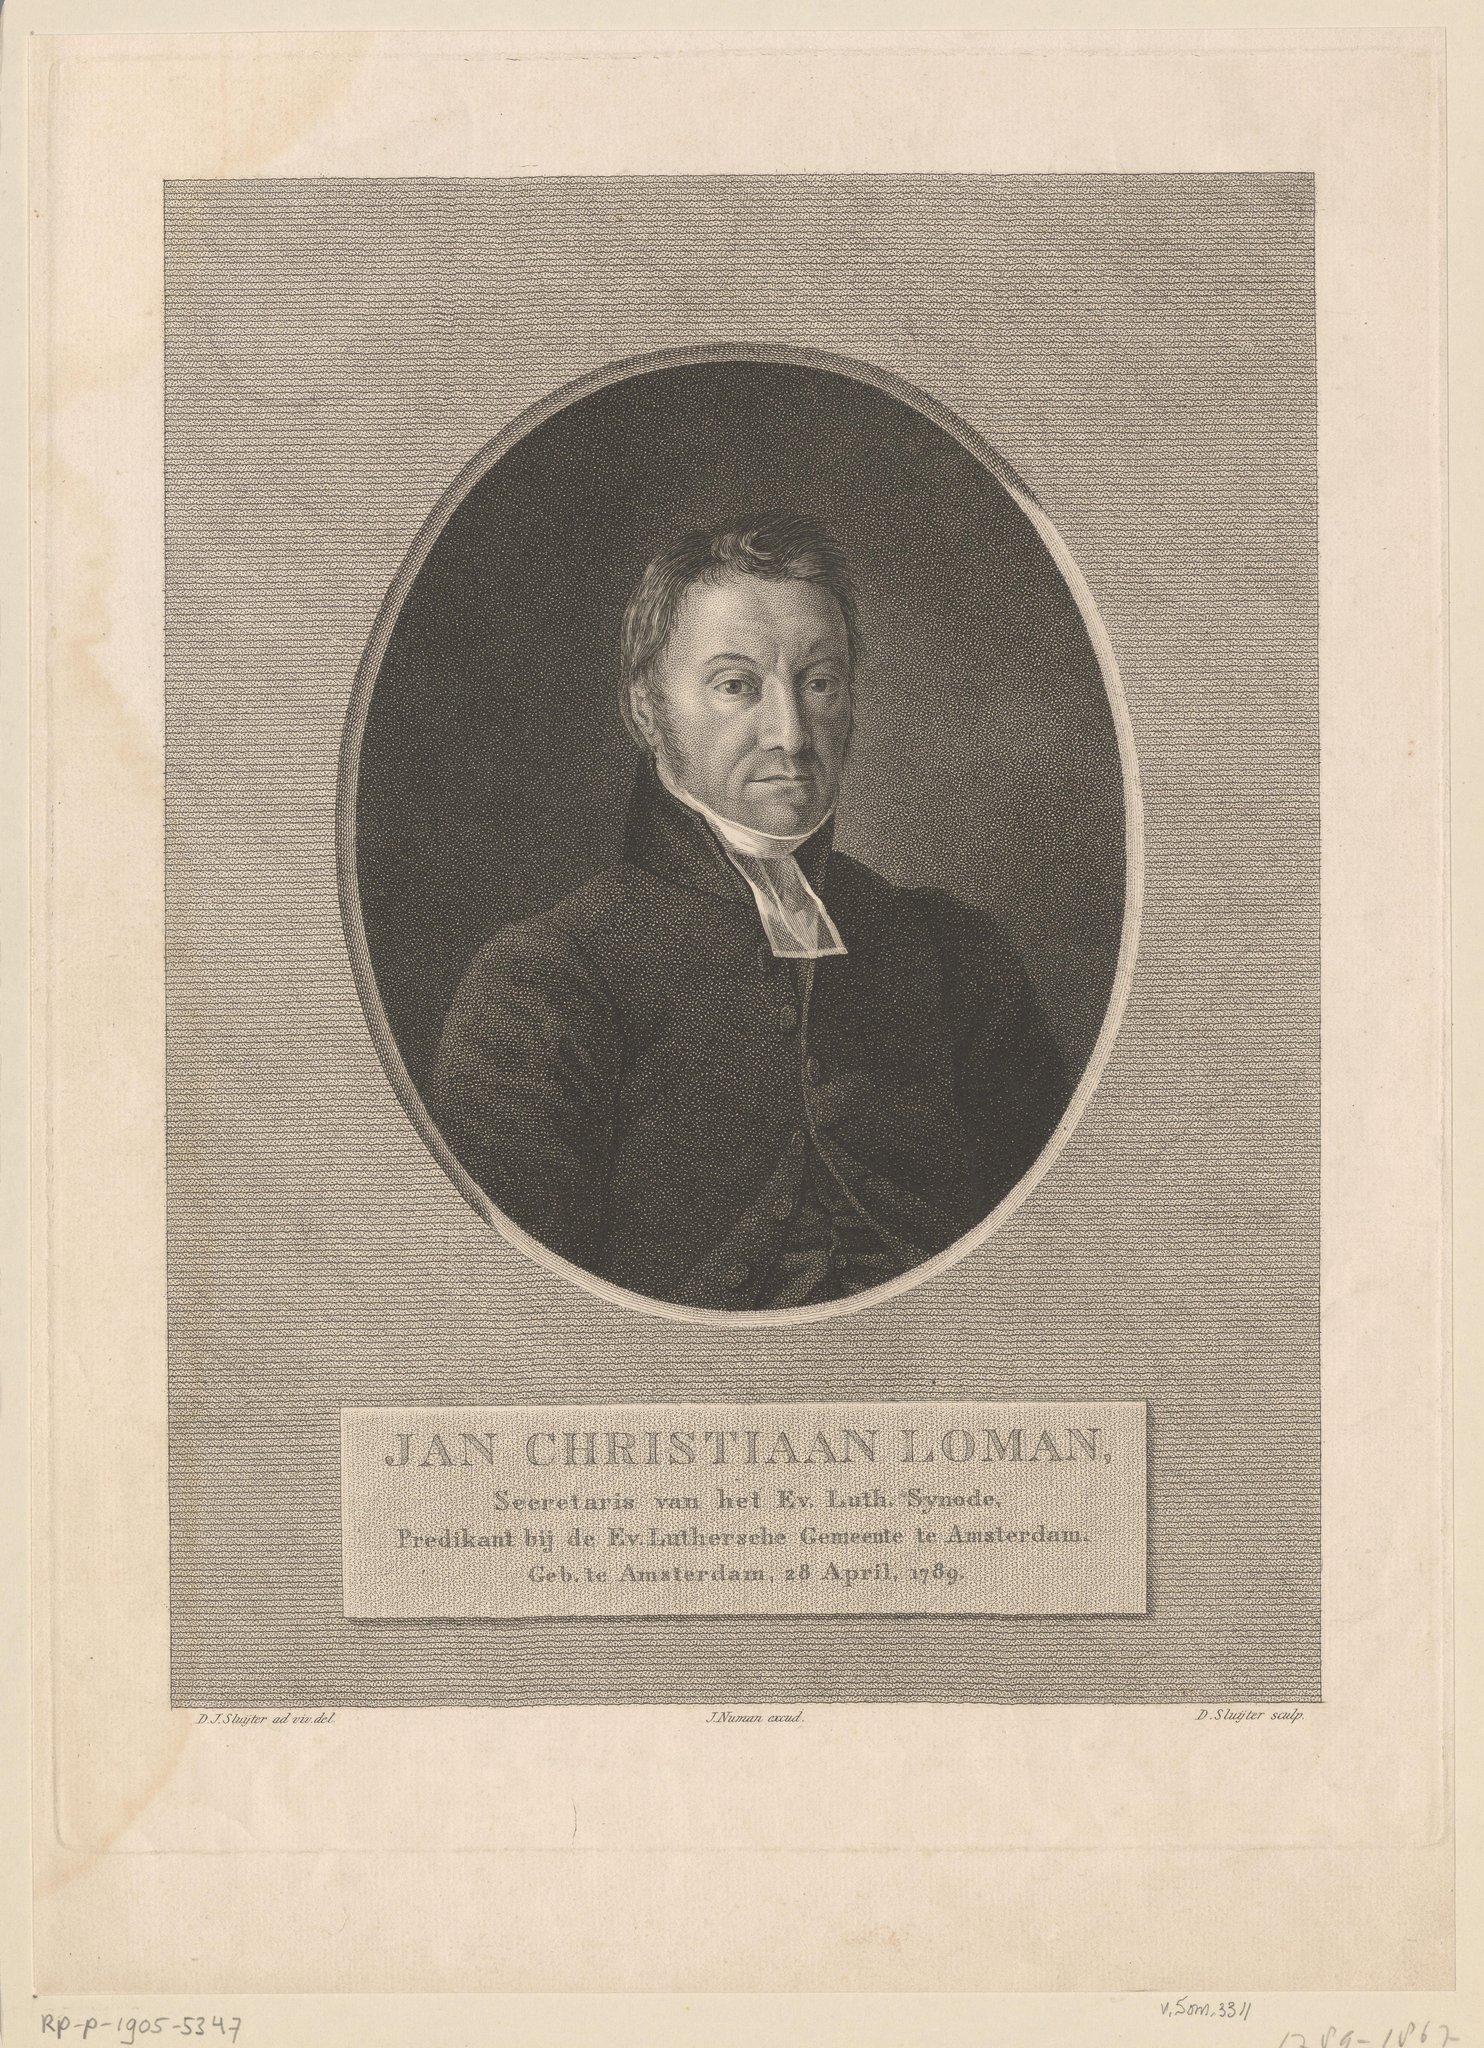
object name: print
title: Portret van Jan Christiaan Loman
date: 1821-1852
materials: paper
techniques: engraving, etching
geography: amsterdam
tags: amsterdam, gouda, ornament ~ medallion, historical persons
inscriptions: collector's mark: Lugt 2228